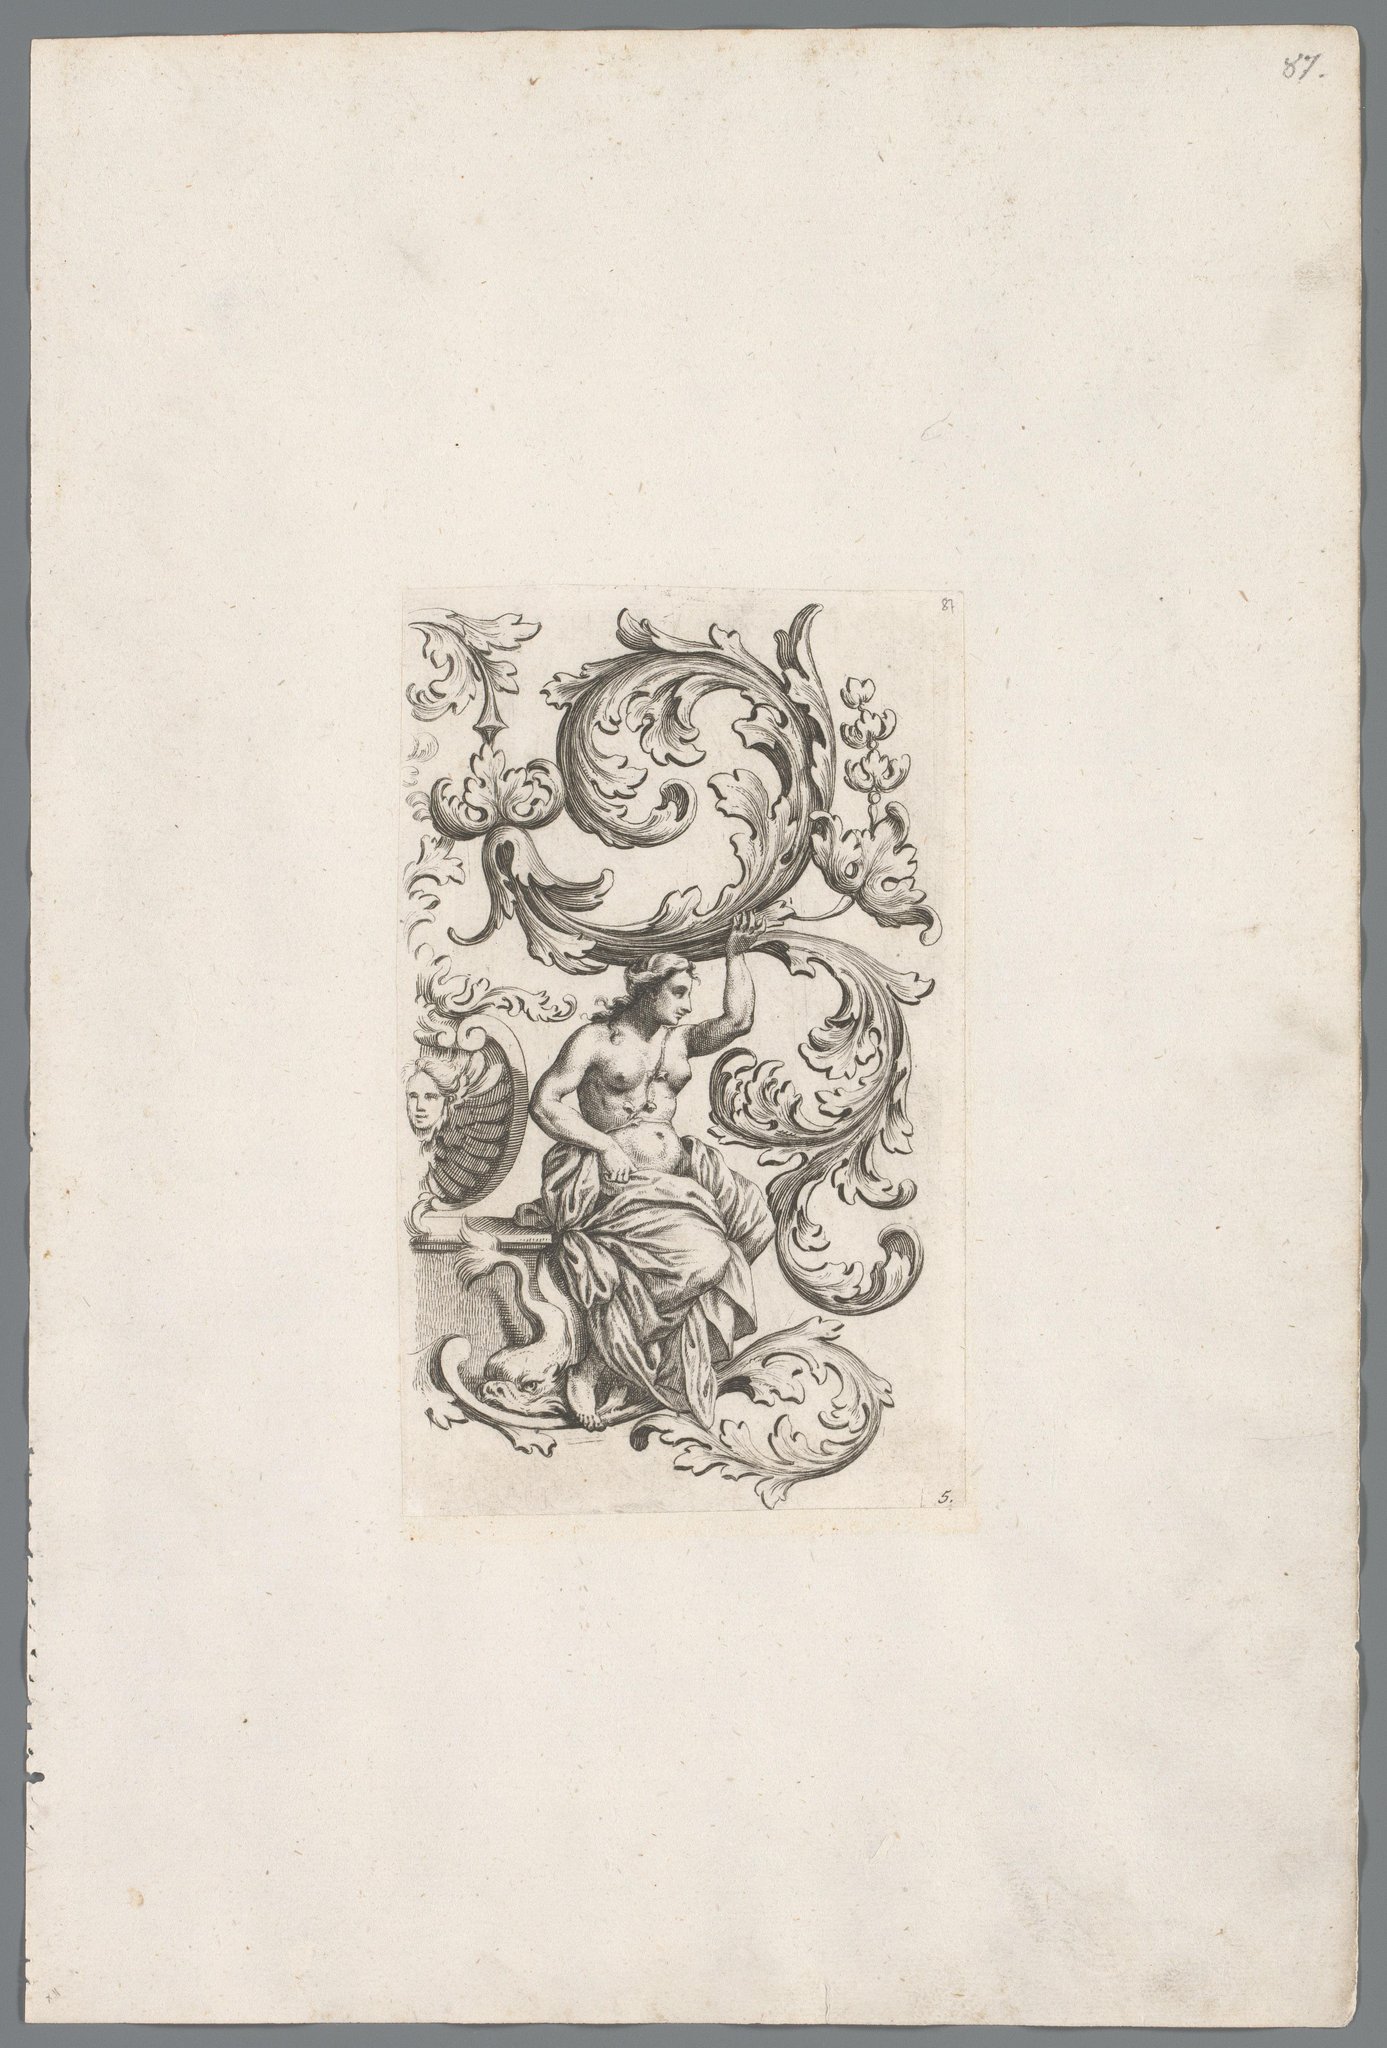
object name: ornament print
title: Ornament met op een dolfijn zittende vrouw die acanthusbladeren omhoog houdt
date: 1679-1700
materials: paper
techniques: etching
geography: augsburg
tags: dolphin ~ ornament, acanthus ~ ornament, woman (showing herself) undressed, quasi-nude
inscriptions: collector's mark: Lugt 2228, collector's mark: Lugt 2760